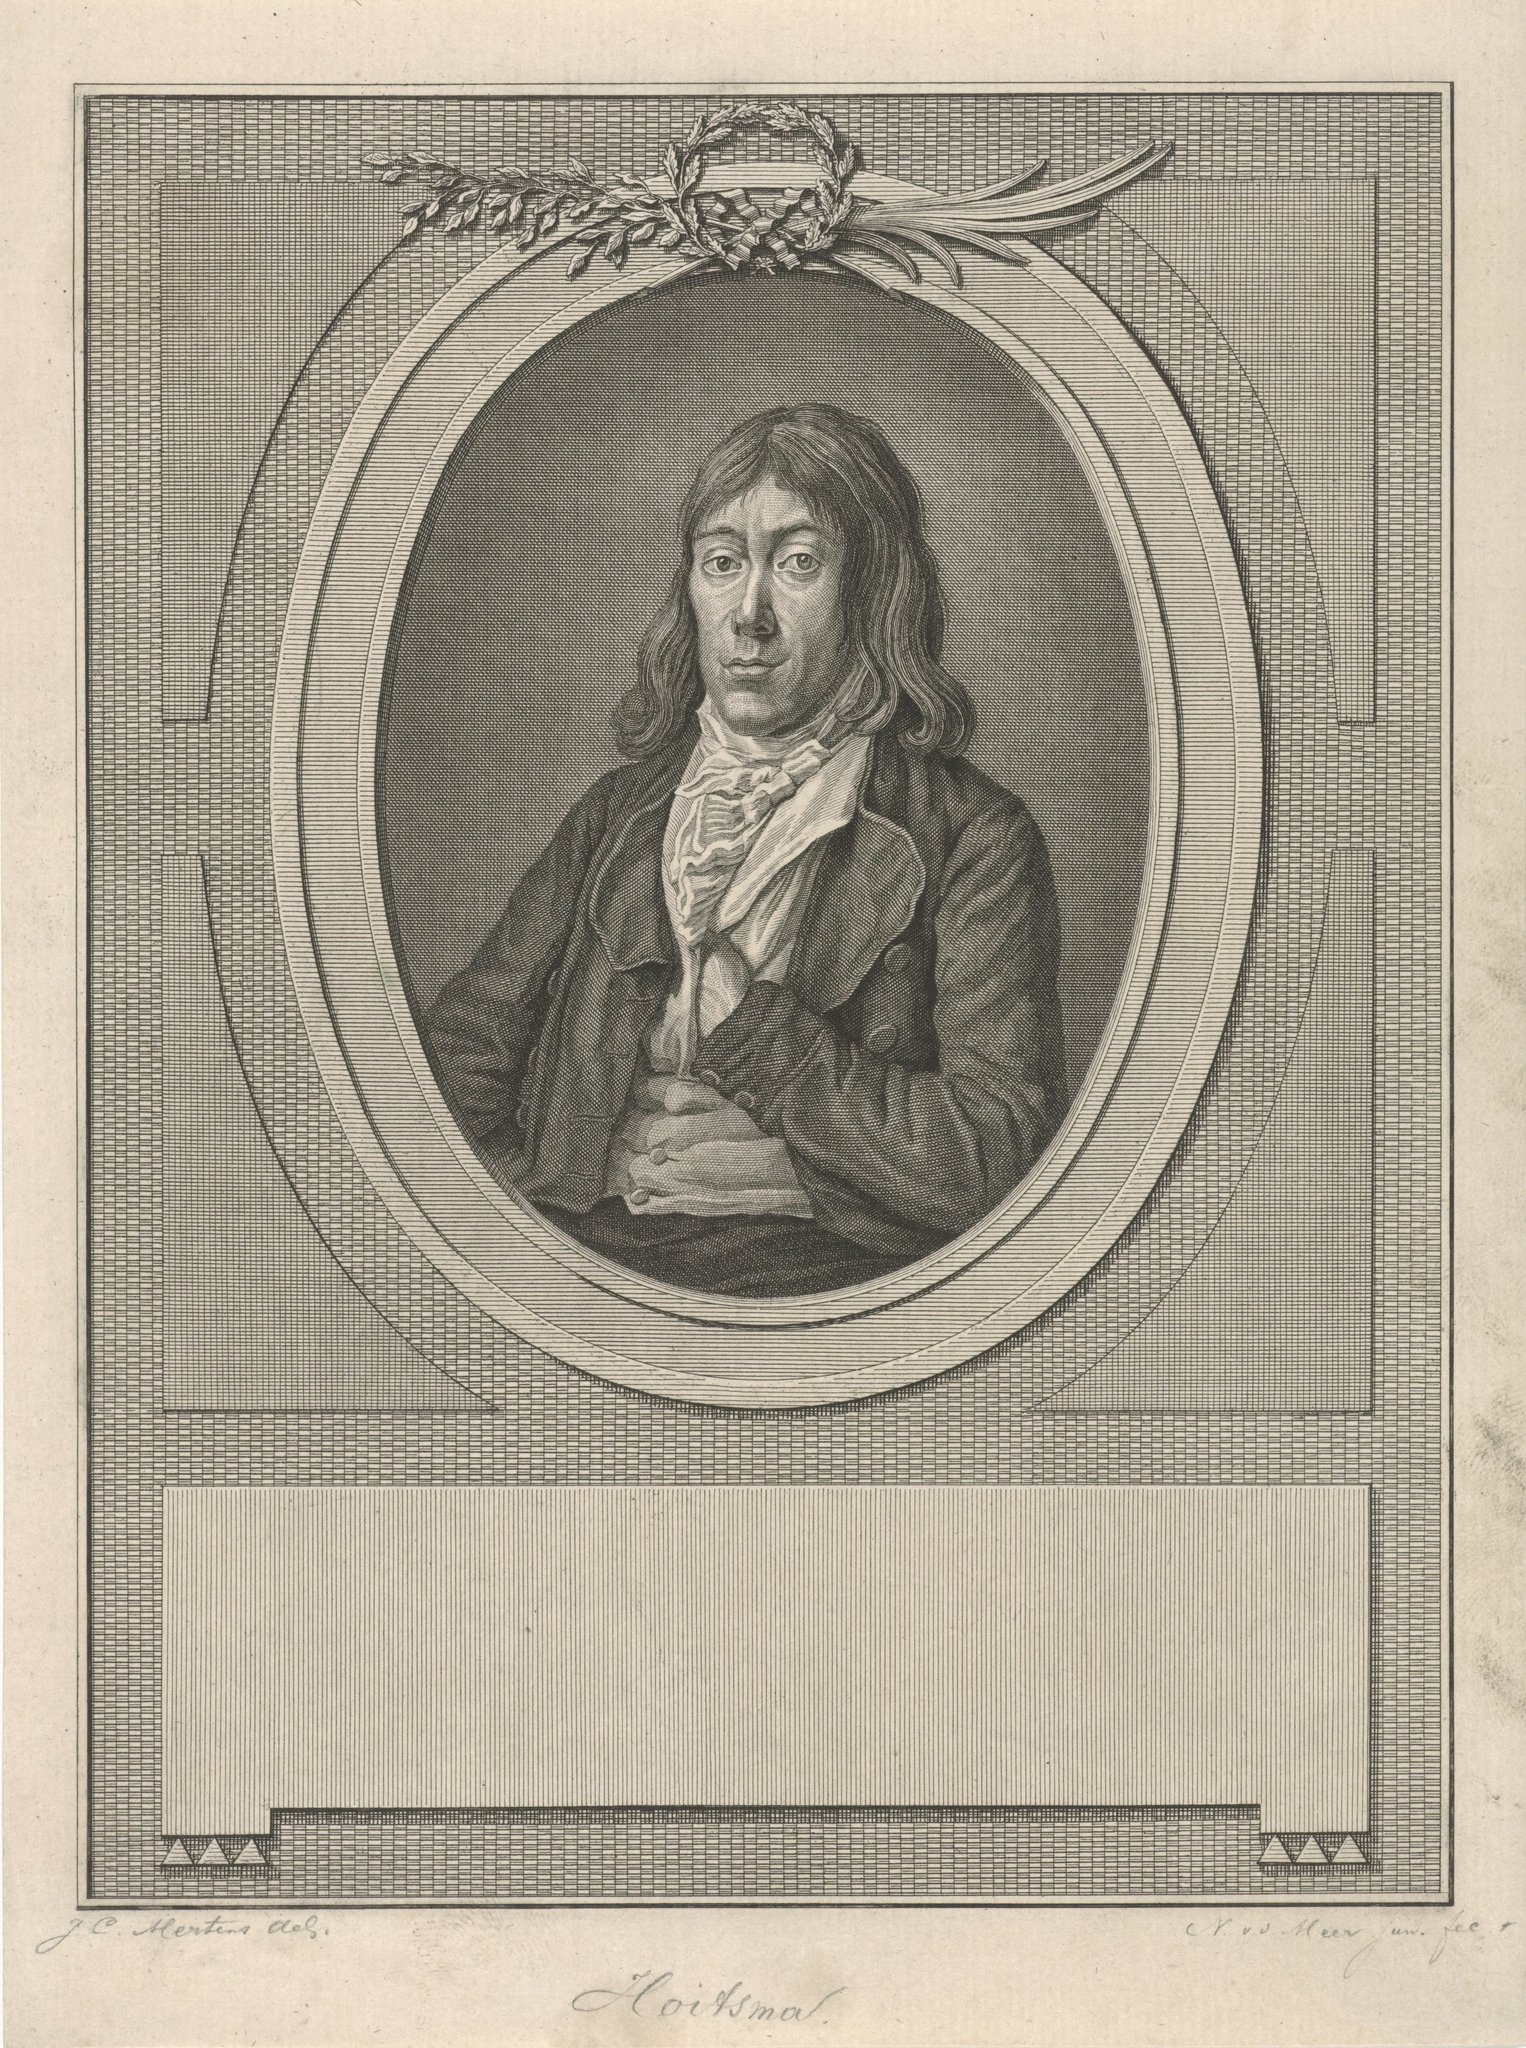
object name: print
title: Portret van Dirk Hoitsma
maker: noach van der meer (ii)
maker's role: draughtsman, print maker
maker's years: 1741-1822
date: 1797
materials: paper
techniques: etching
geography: amsterdam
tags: politician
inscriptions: collector's mark: Lugt 2228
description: Portret van Dirk Hoitsma, lid van het provinciaal bestuur van Holland.